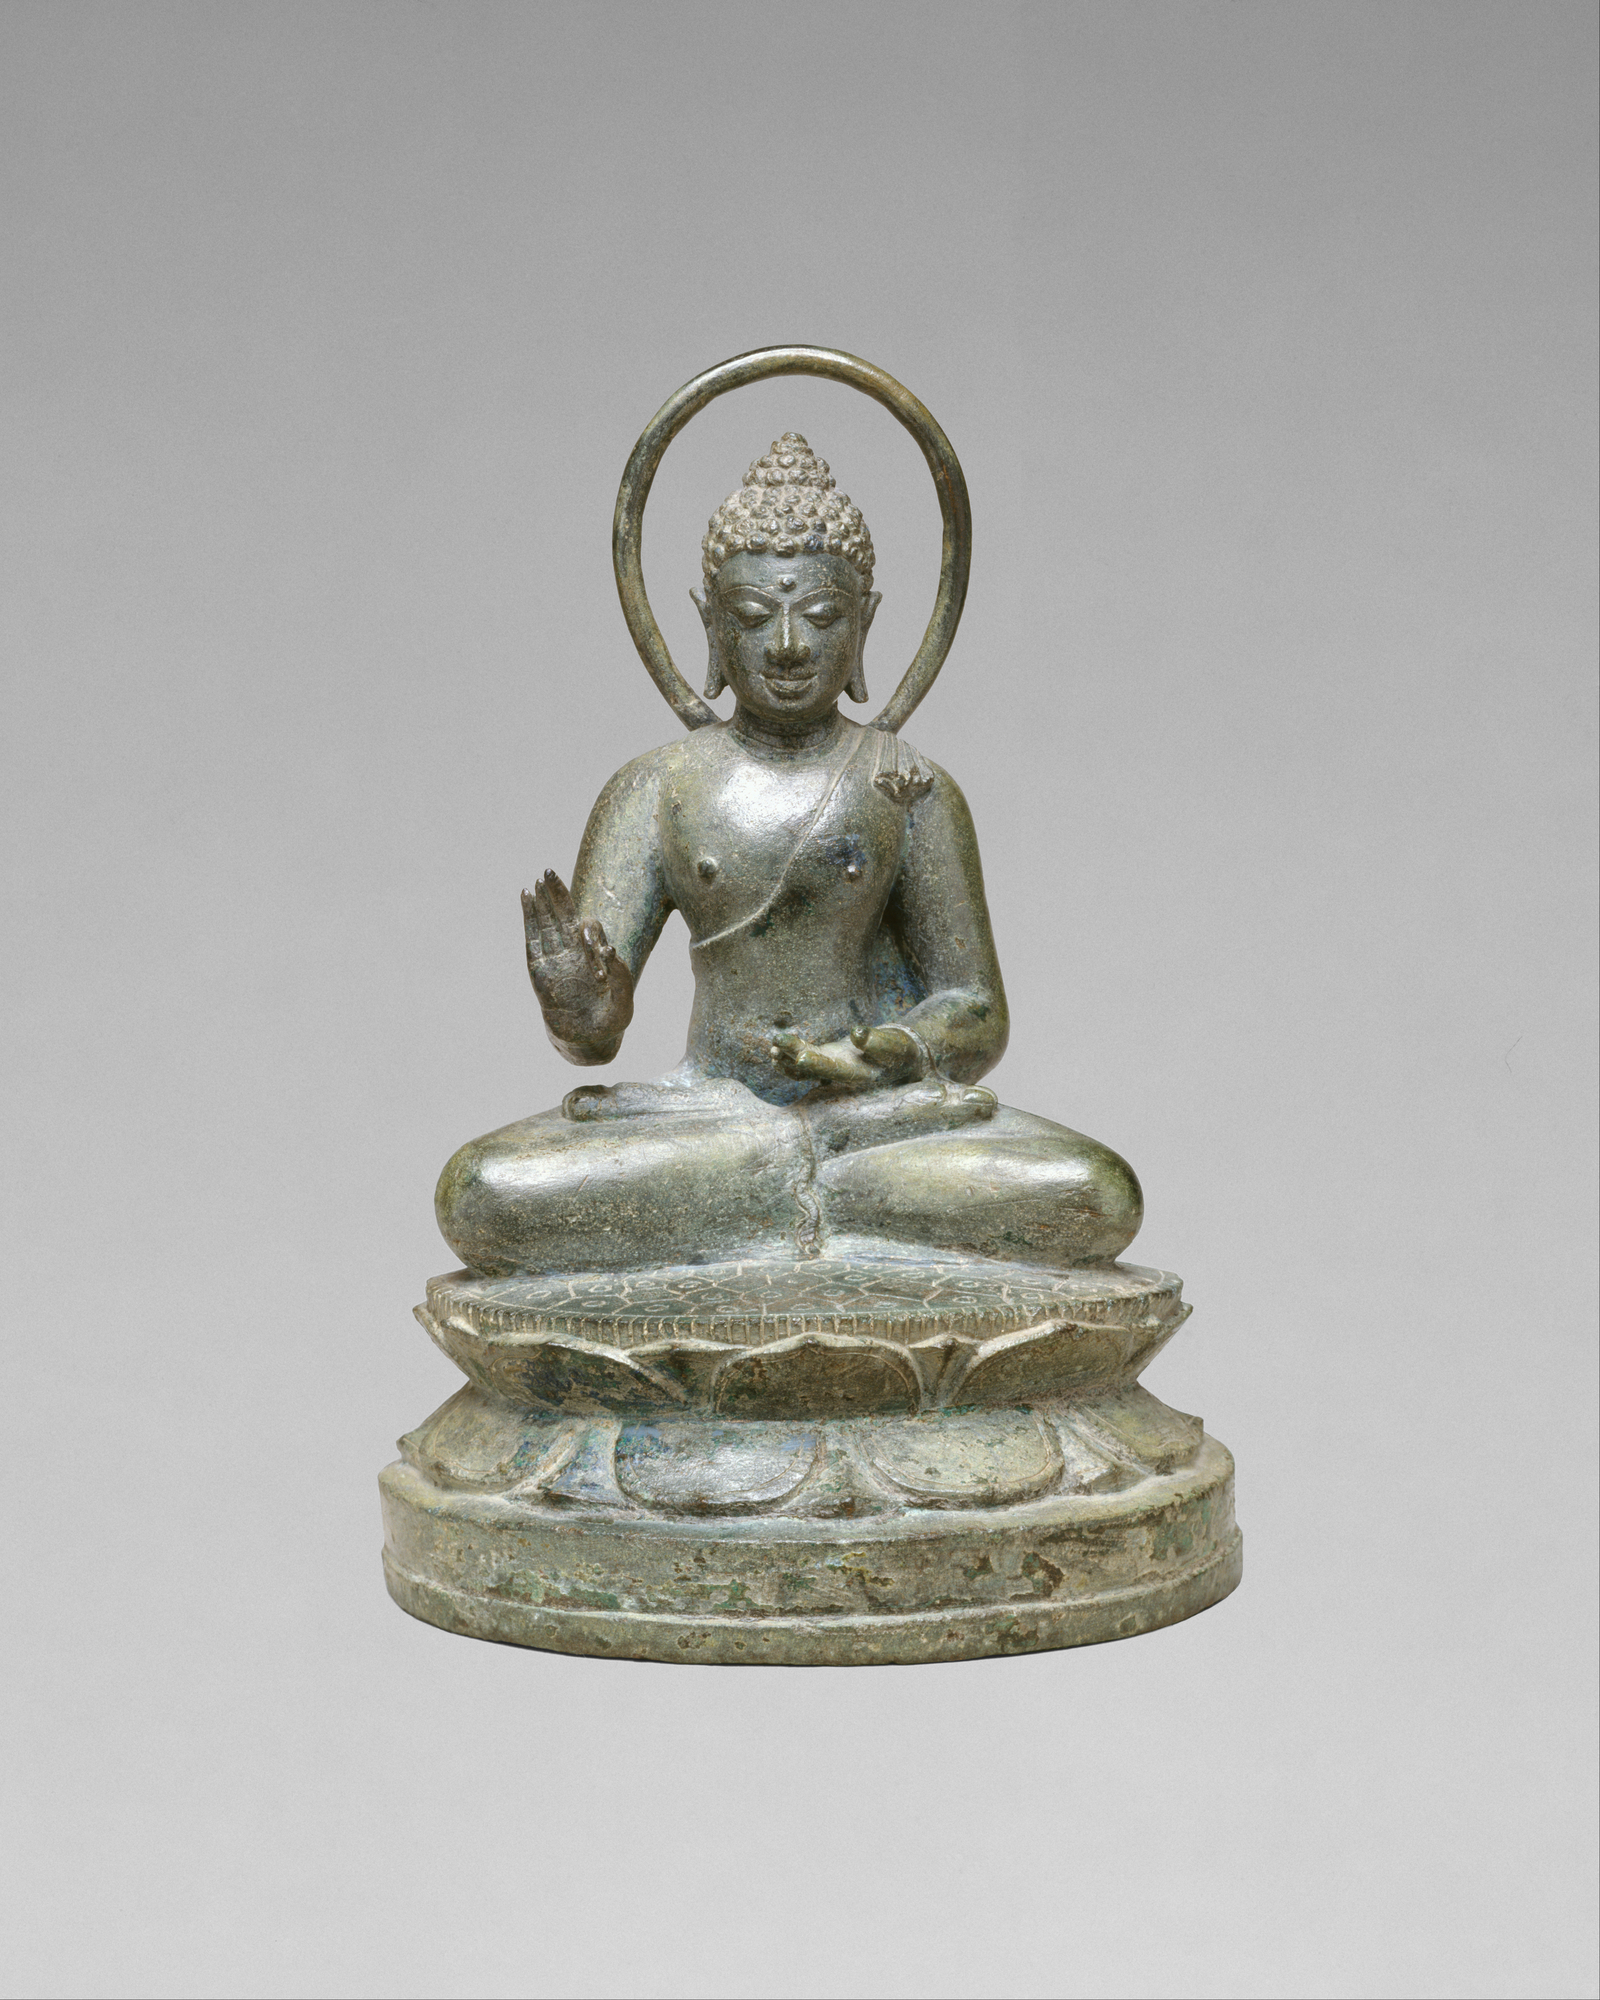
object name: figure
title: Seated Transcendent Buddha Vairochana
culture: indonesian, javanese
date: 867-900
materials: bronze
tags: buddhism,buddha